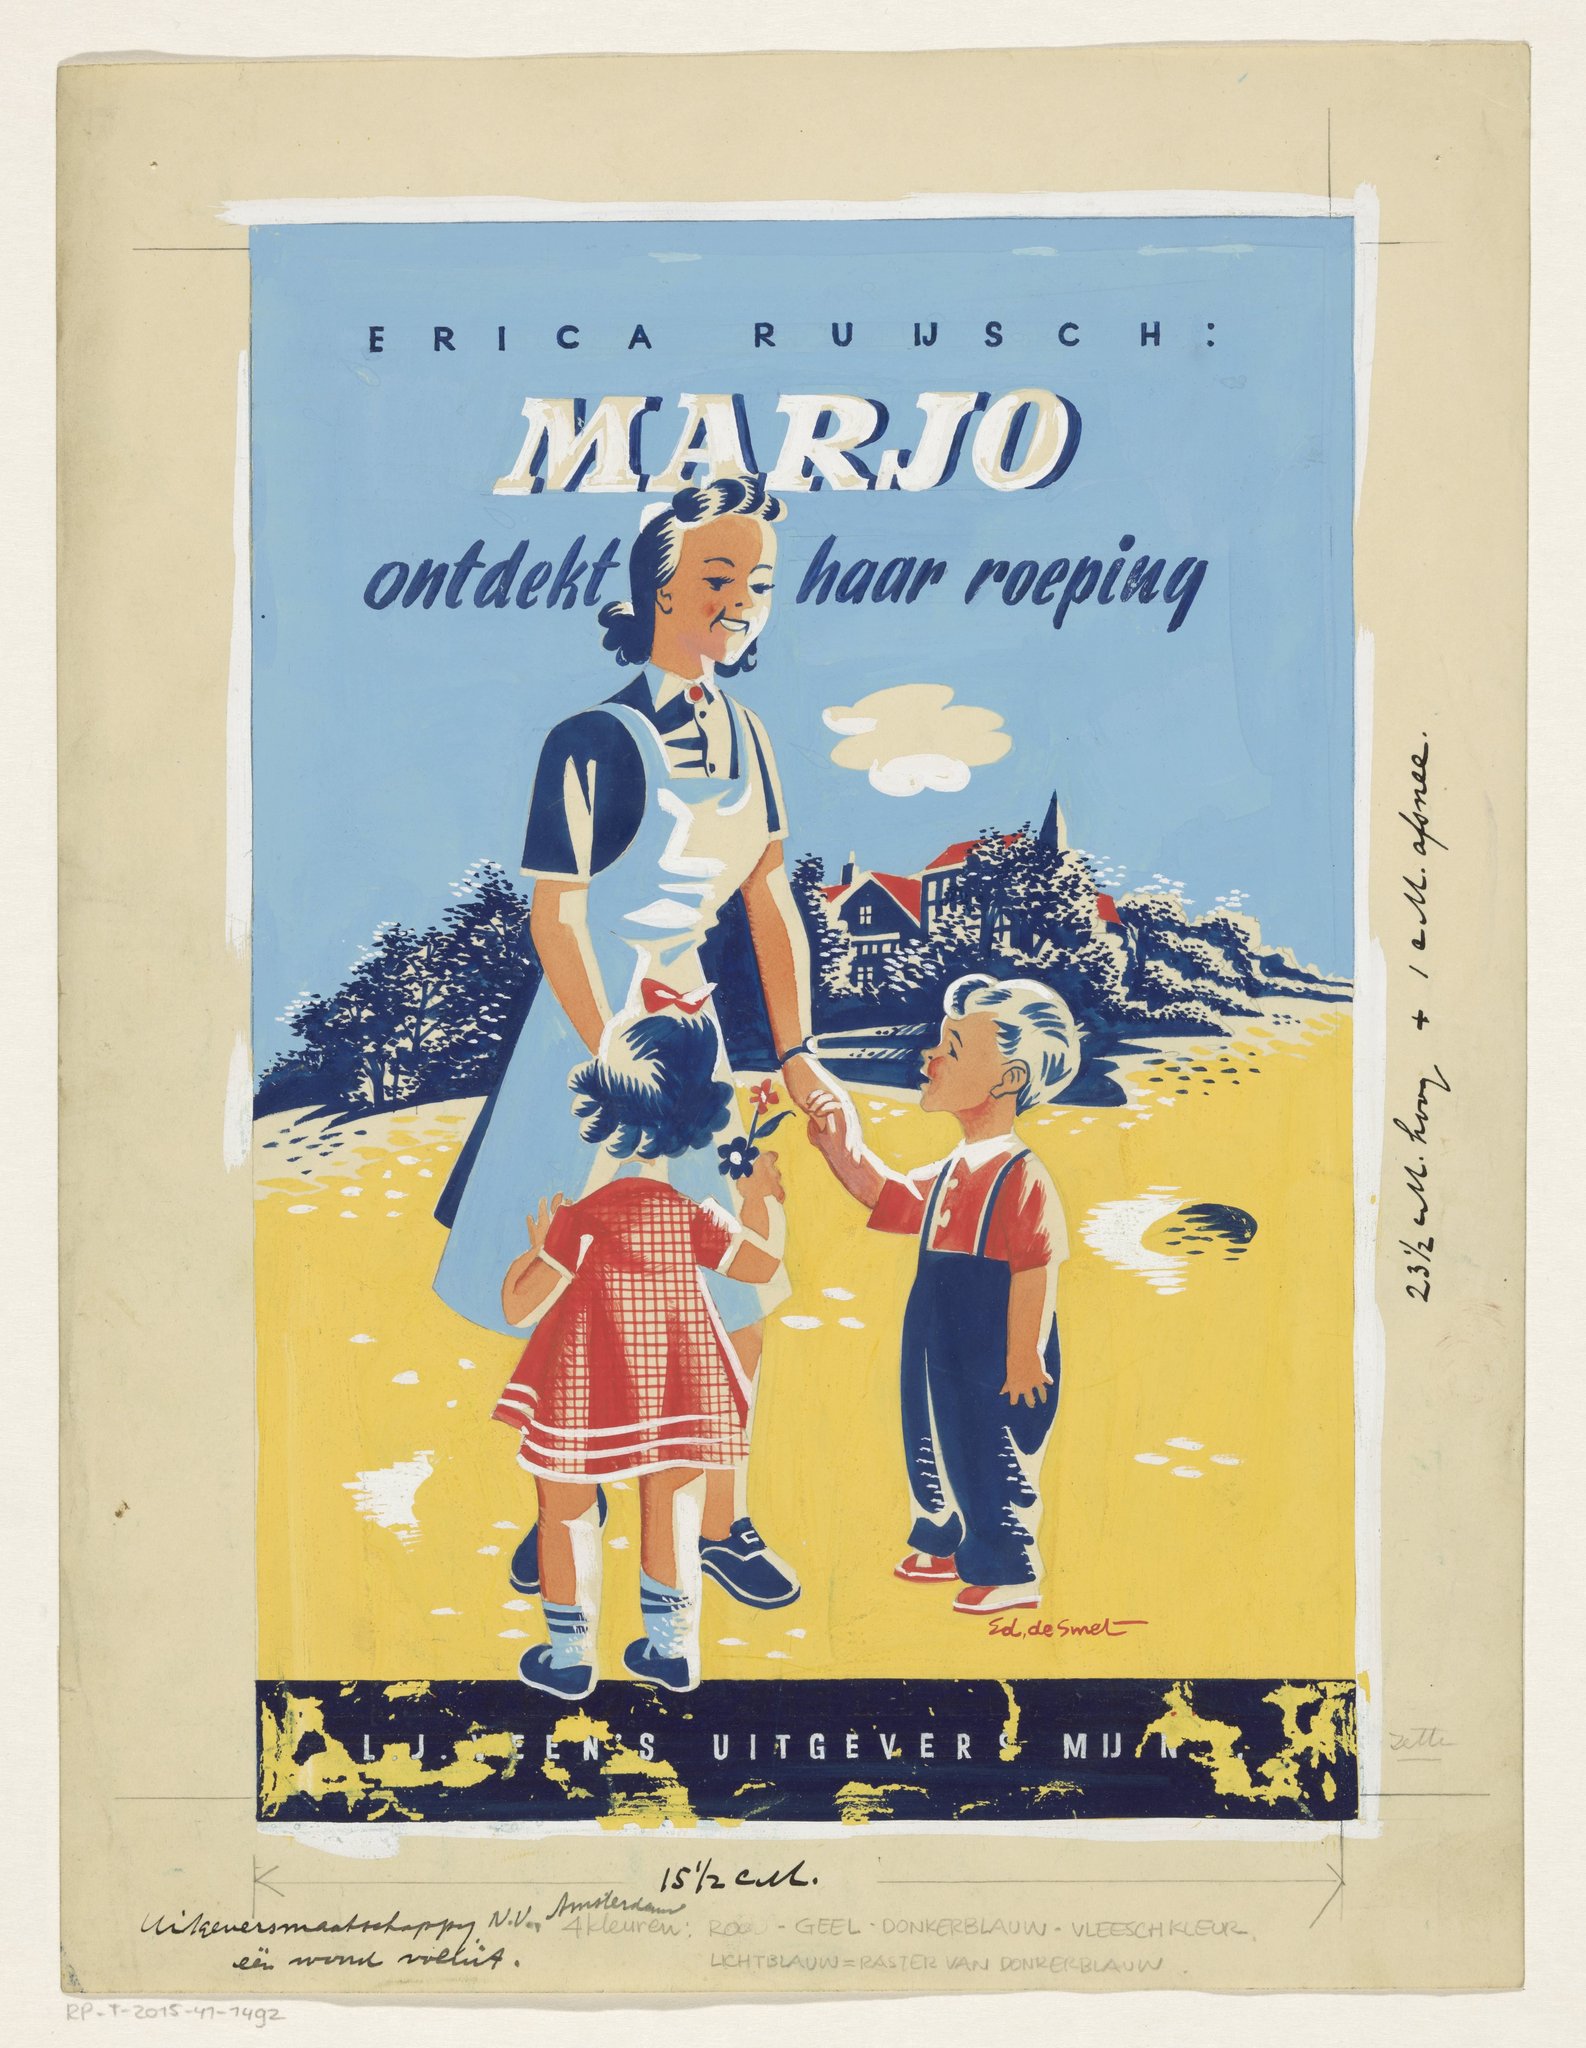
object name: study for binding design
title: Bandontwerp voor: Erica Ruijsch, Marjo ontdekt haar roeping, 1946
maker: eddy de smet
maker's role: draughtsman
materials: paint, paper, pencil, watercolor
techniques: brush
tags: prospect of village, silhouette of village, flowers, baby-sitter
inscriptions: collector's mark: Lugt 2228, :, signature: ‘Ed, de Smet’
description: Een jonge vrouw met een schort voor haar jurk staat in een landschap met een jongen en meisje. De jongen houdt de hand van de vrouw vast. Het meisje reikt haar een bloem aan. In de achtergrond huizen en bomen.